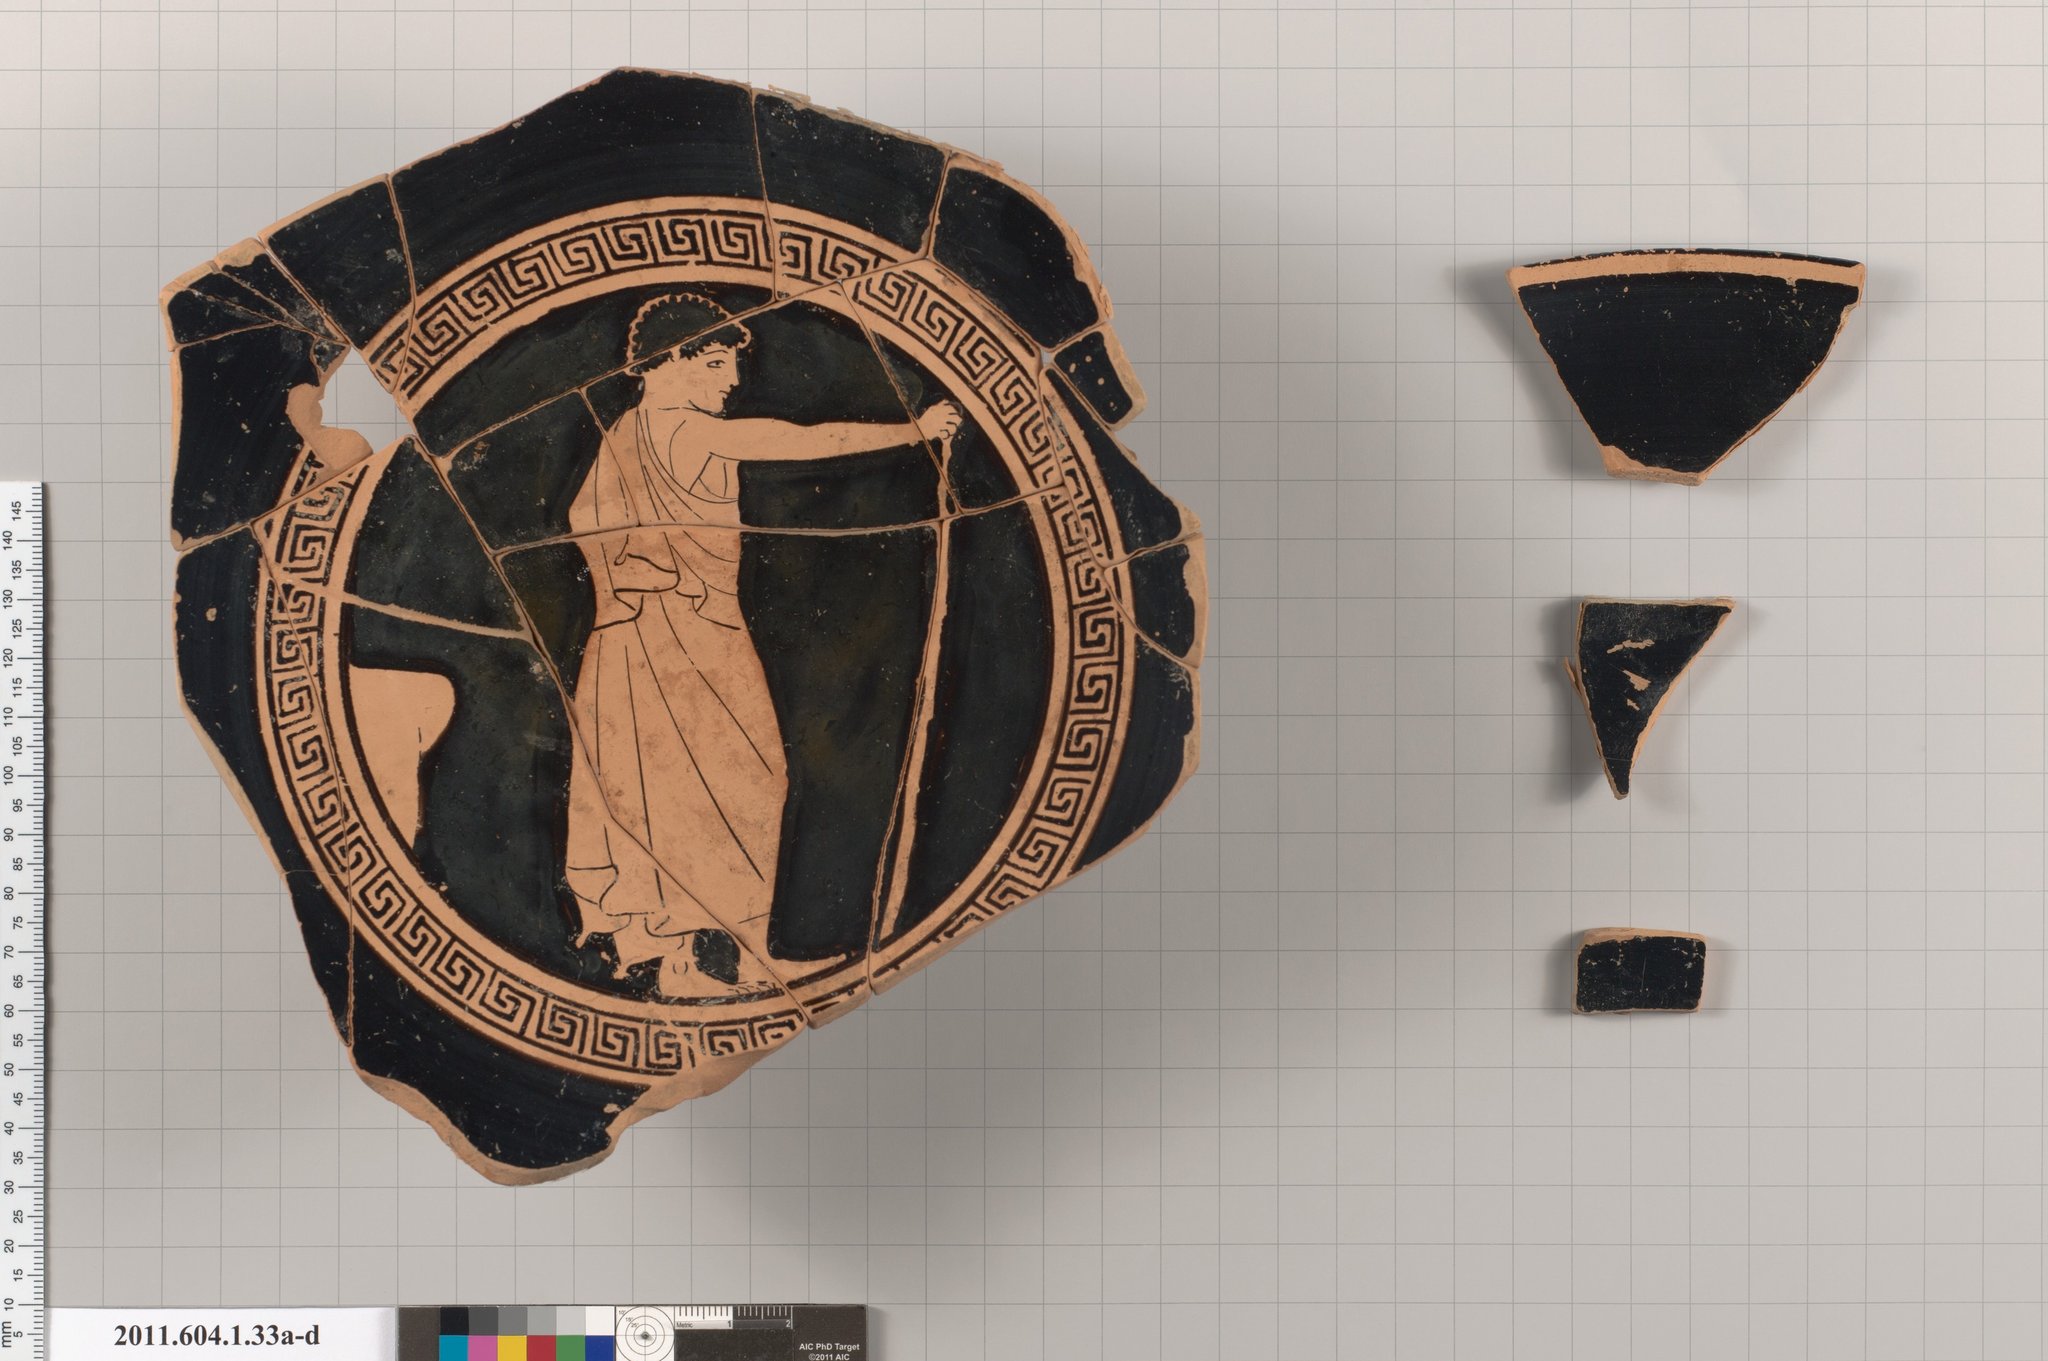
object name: kylix fragment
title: Terracotta fragments of a kylix (drinking cup)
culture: greek, attic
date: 490-480 BCE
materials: terracotta